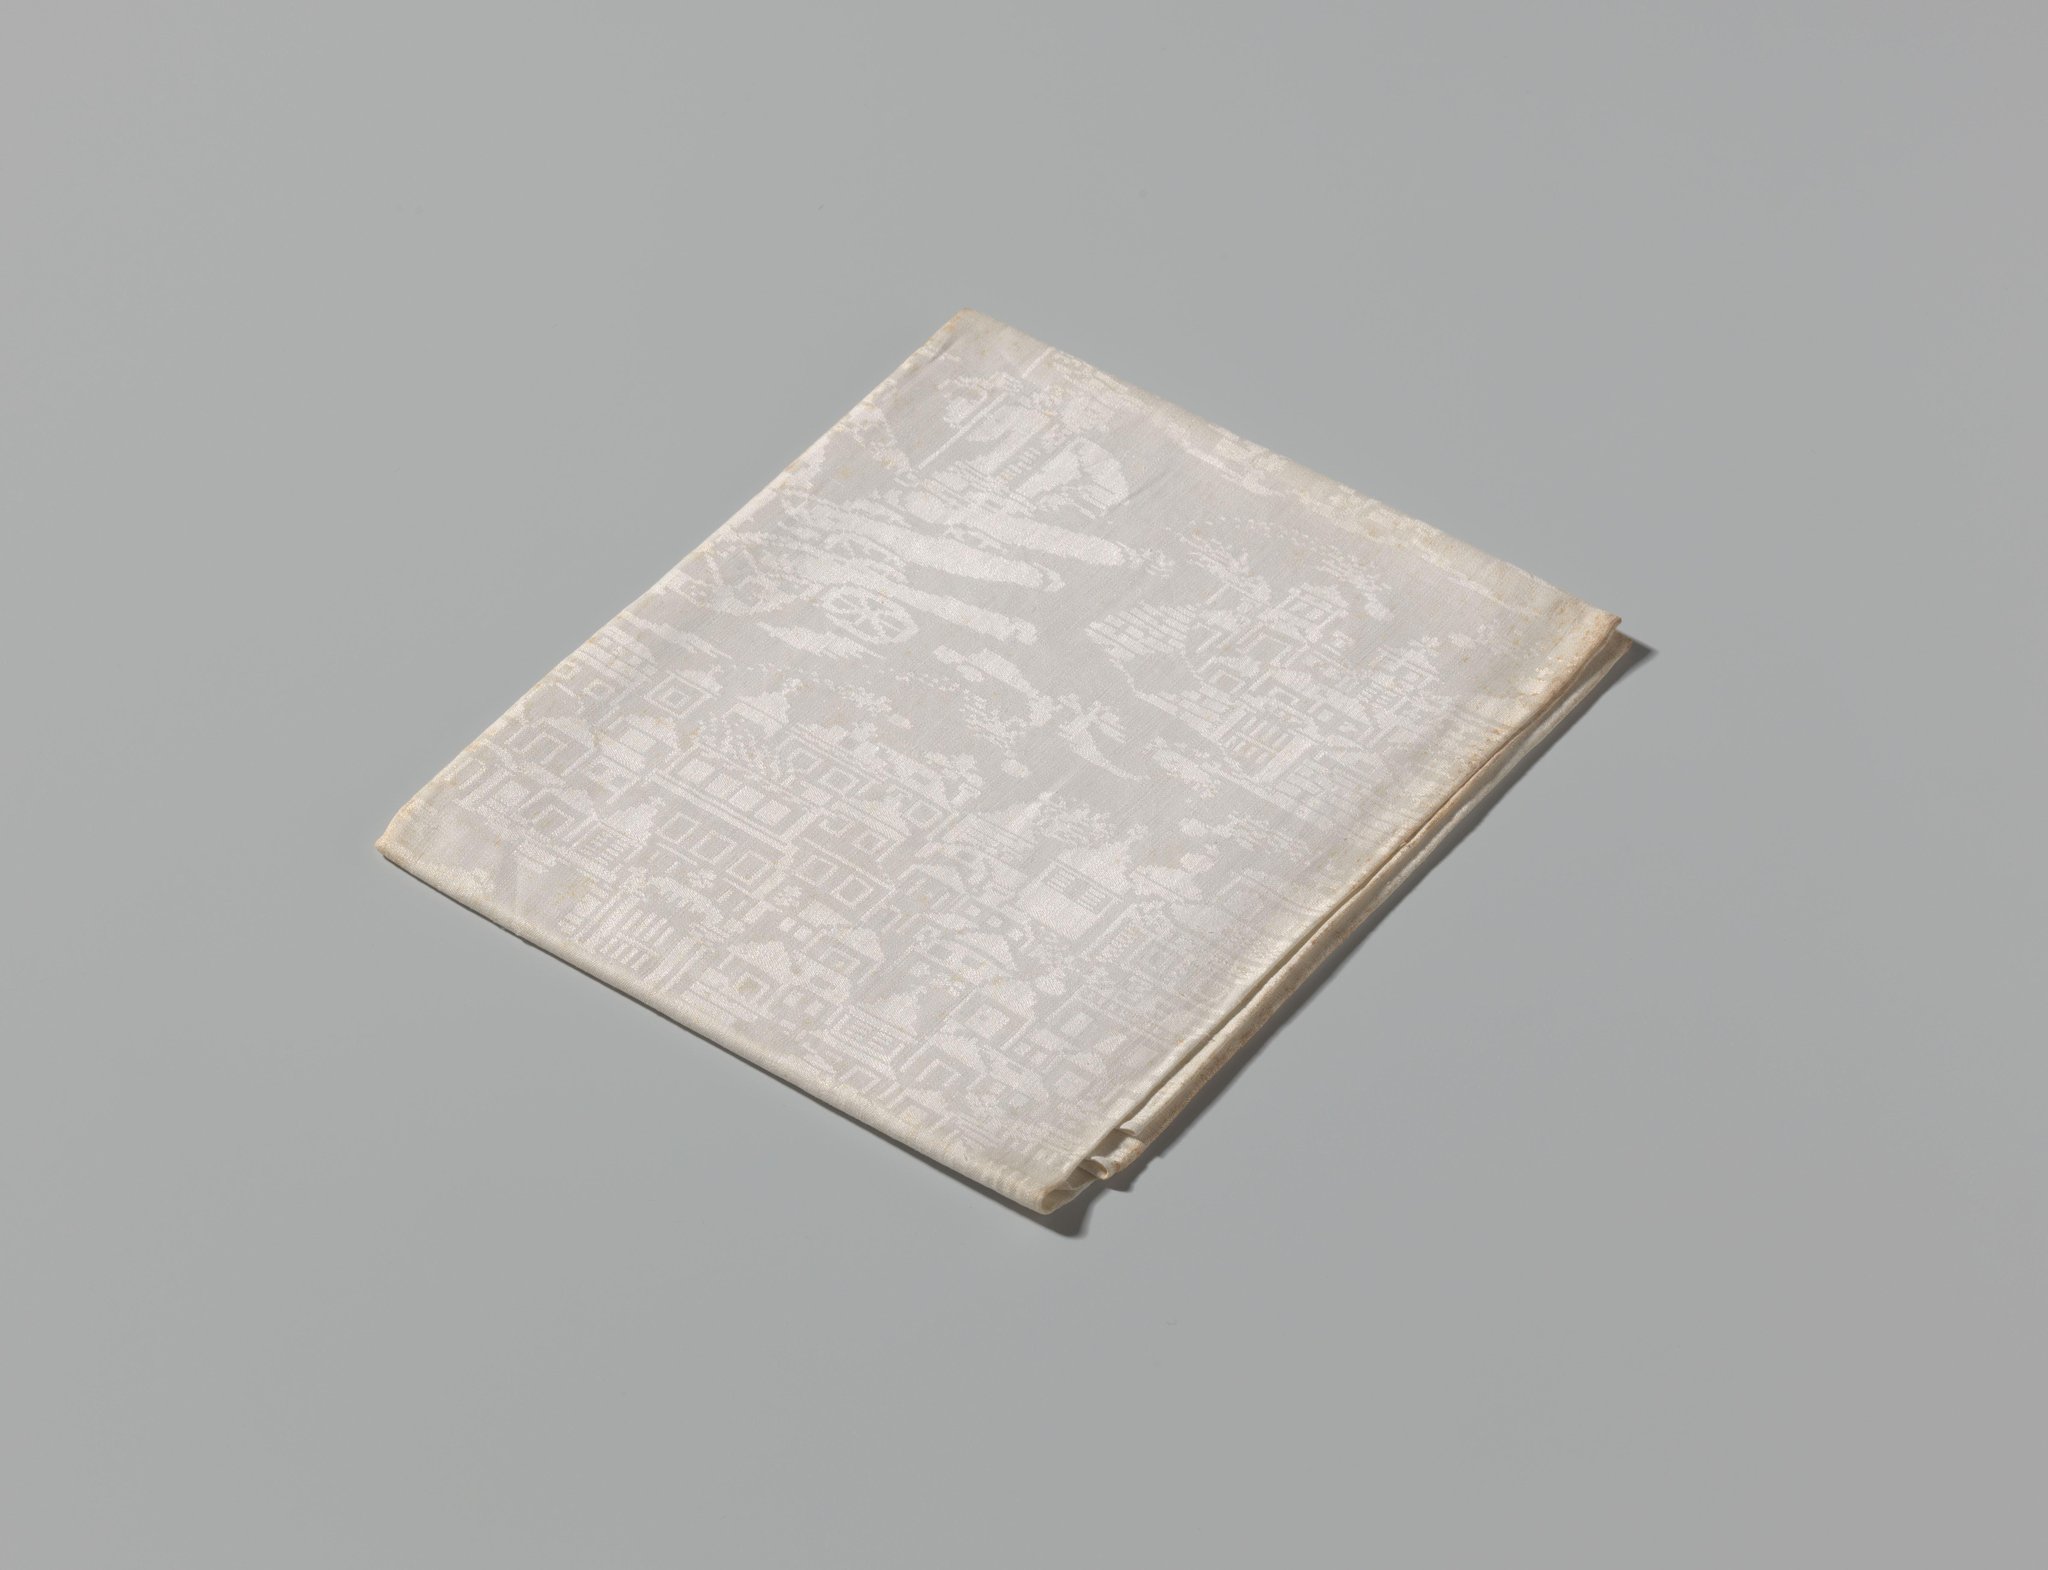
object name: napkin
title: Servet van wit linnendamast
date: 1708-1709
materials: linen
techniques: damask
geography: flanders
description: Wit linnen damasten servet met de verovering van Lille en het inschrift "PRINCEPS EVGENIUS INSVLAS DEBELLAVIT 1708".